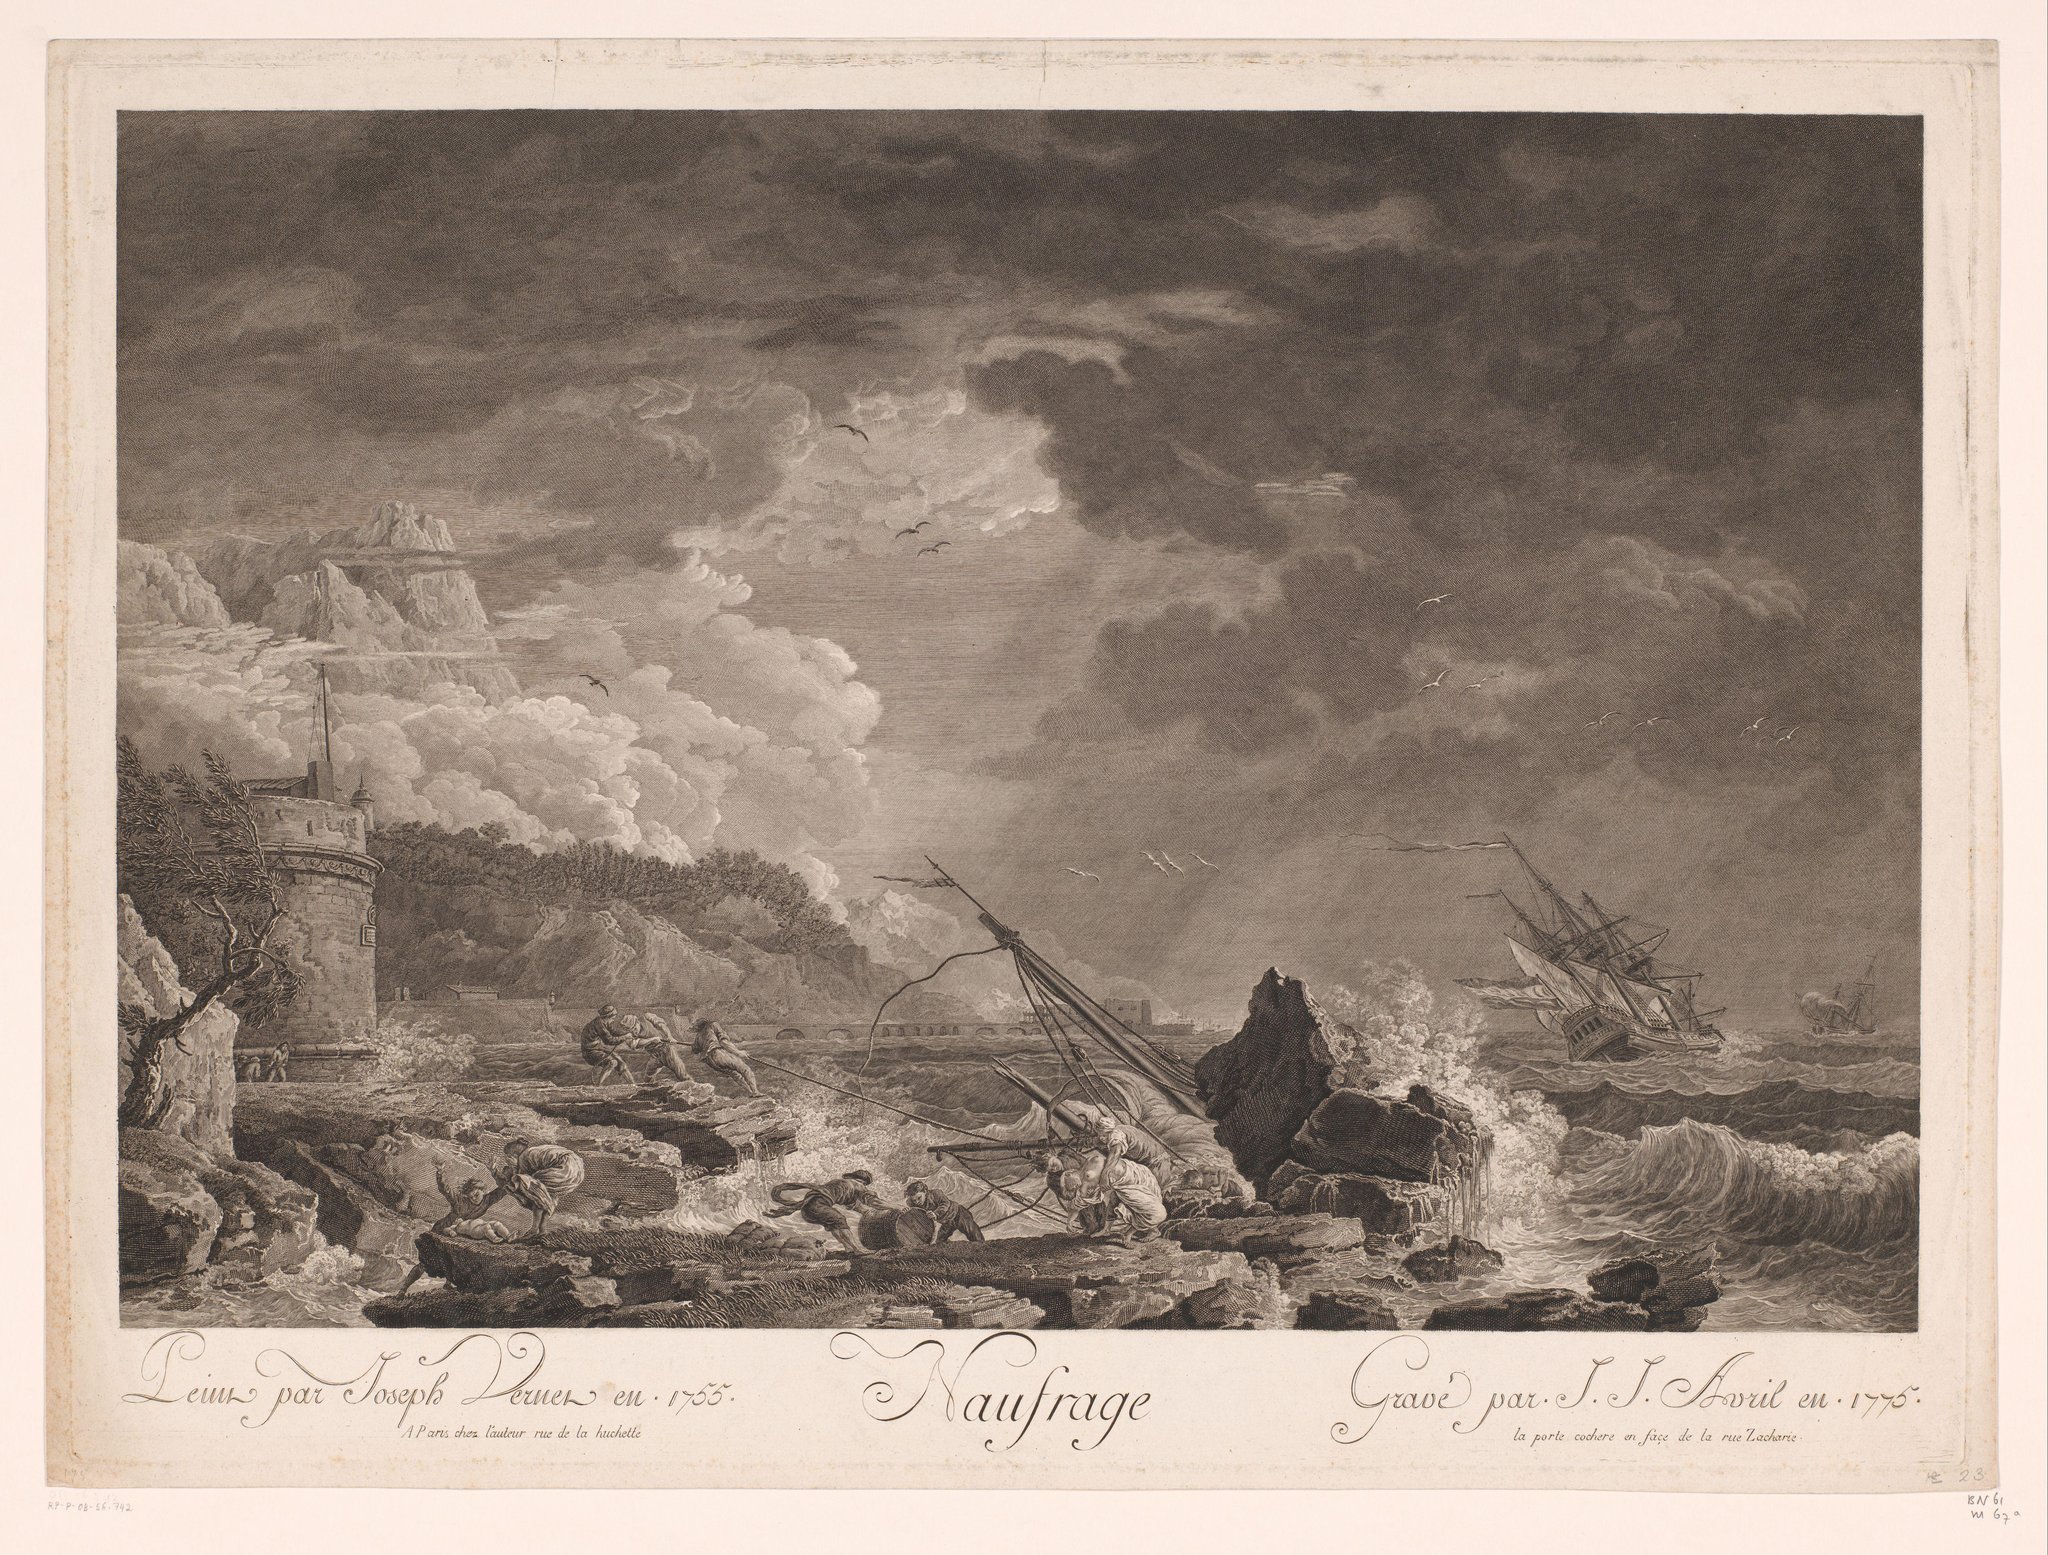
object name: print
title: Naufrage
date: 1755-1775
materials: paper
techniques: etching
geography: france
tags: shipwreck, landscape with tower or castle, storm at sea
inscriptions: collector's mark: Lugt 2228